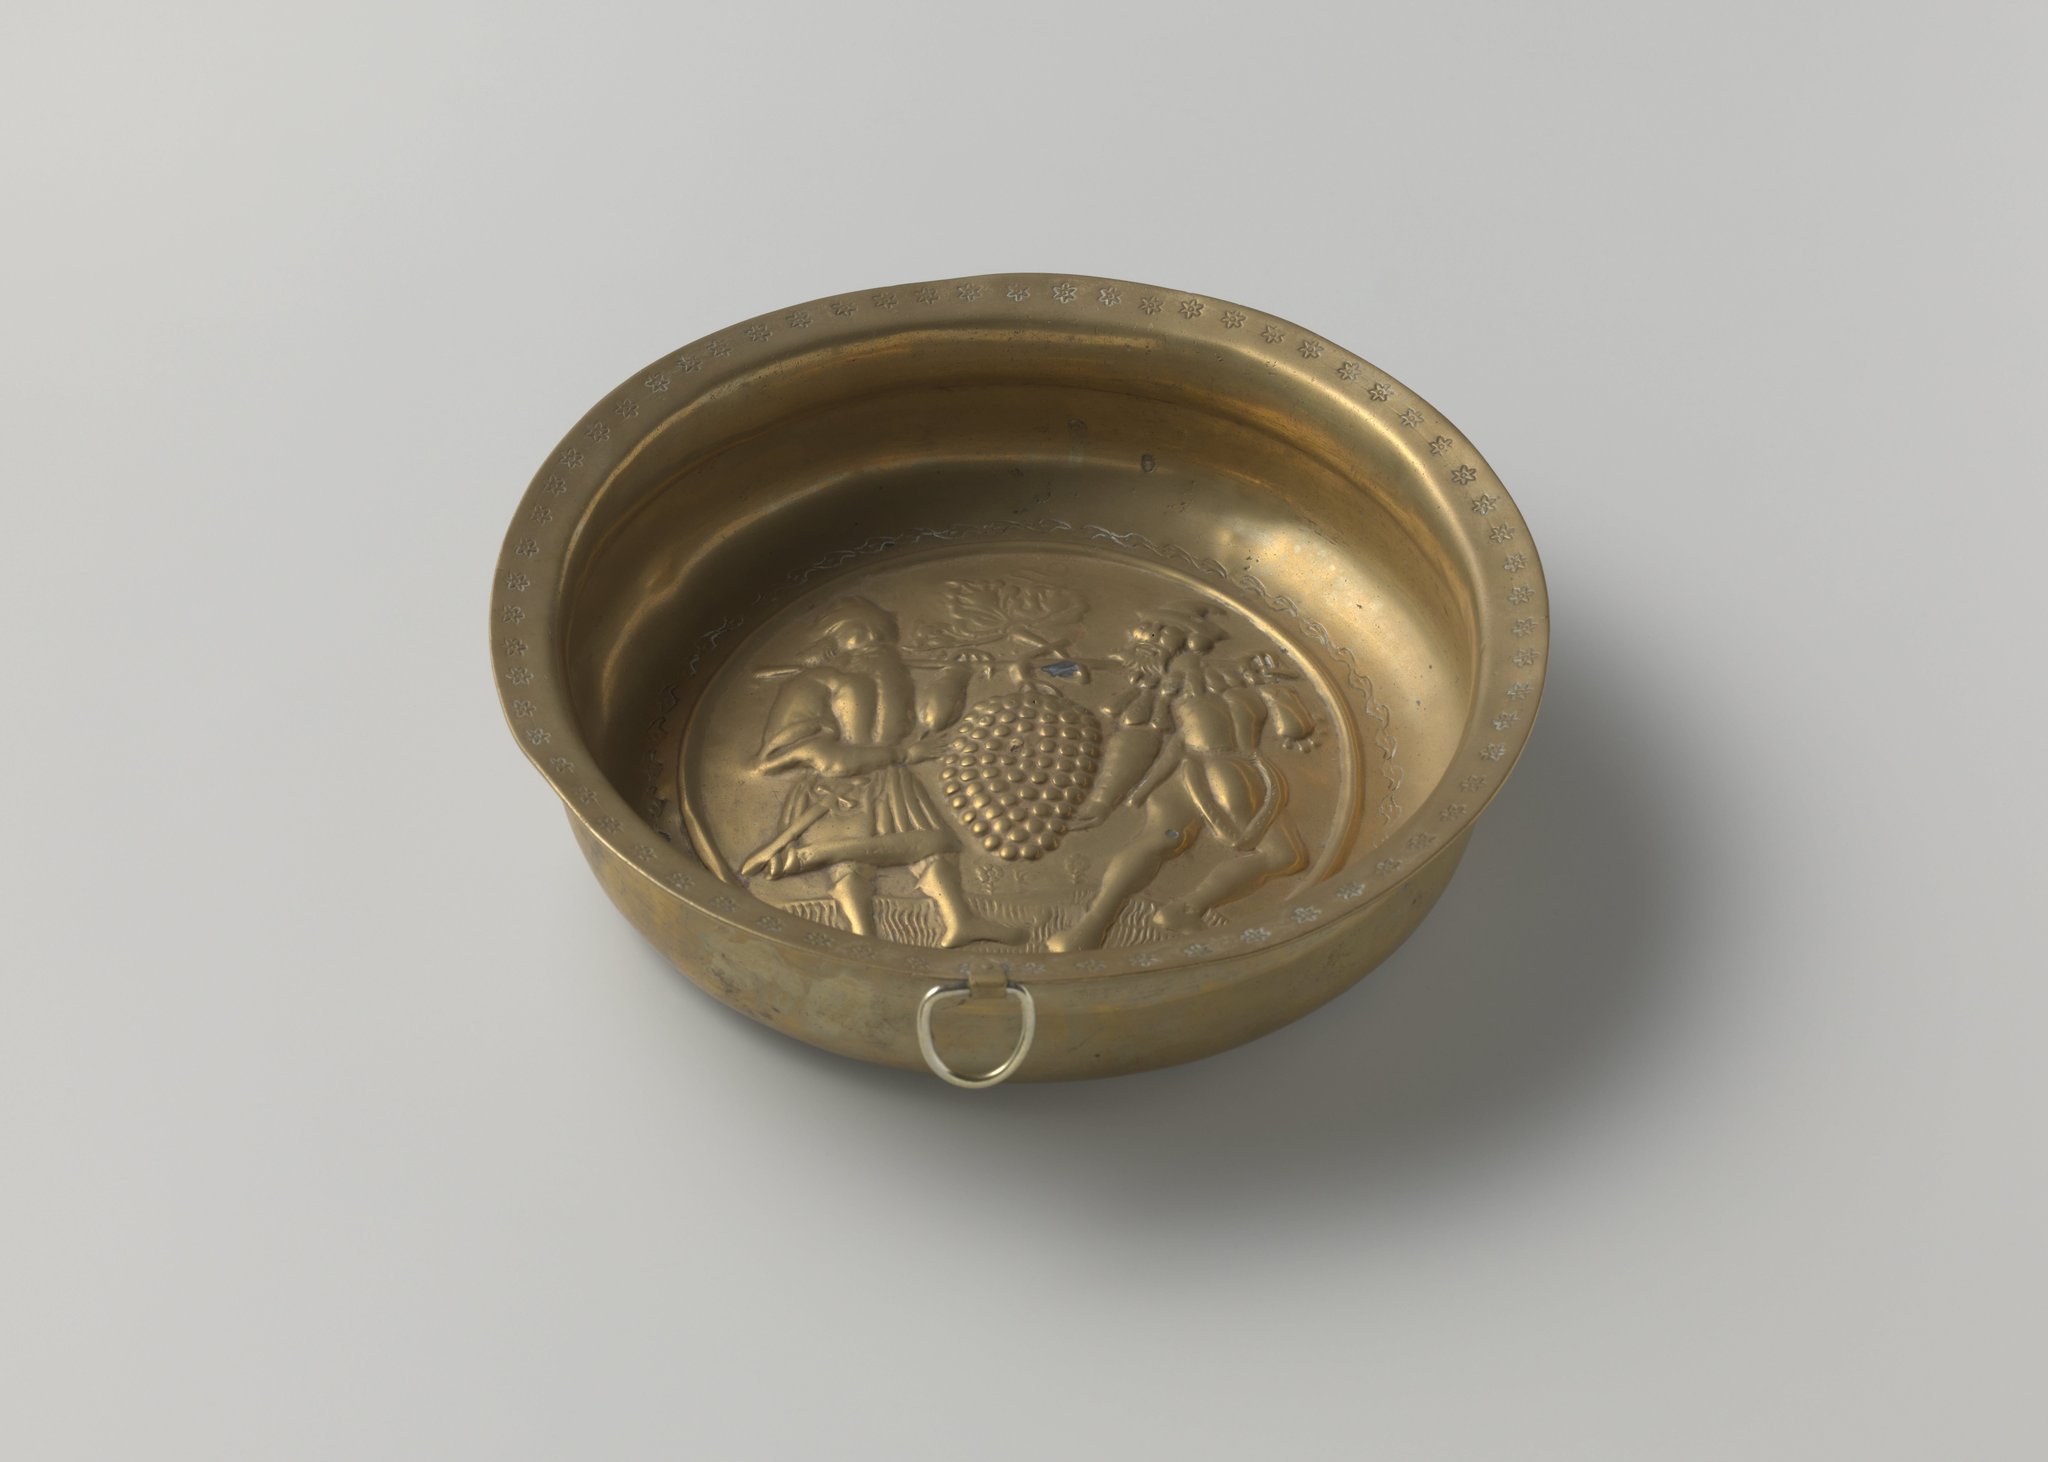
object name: bekken schaal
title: Bekken met de Verspieders van het land Kanaän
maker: Anonymous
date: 1450-1500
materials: brass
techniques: casting, metalworking, punching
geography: nuremberg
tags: the spies take away some of the fruits of canaan and return, usually carrying a large bunch of grapes on a pole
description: In het plat van het bekken, dat in het midden het centerpunt heeft, is met behulp van een stempelvorm een voorstelling geponst van de Verspieders van het land Kanaän (Jozua 2, 1-22). Deze is omgeven door een met ponsstempels geslagen rand van gestileerde bladeren. Op de boord zijn op die wijze rozetten aangebracht en is in latere tijd onderaan een hangring bevestigd.